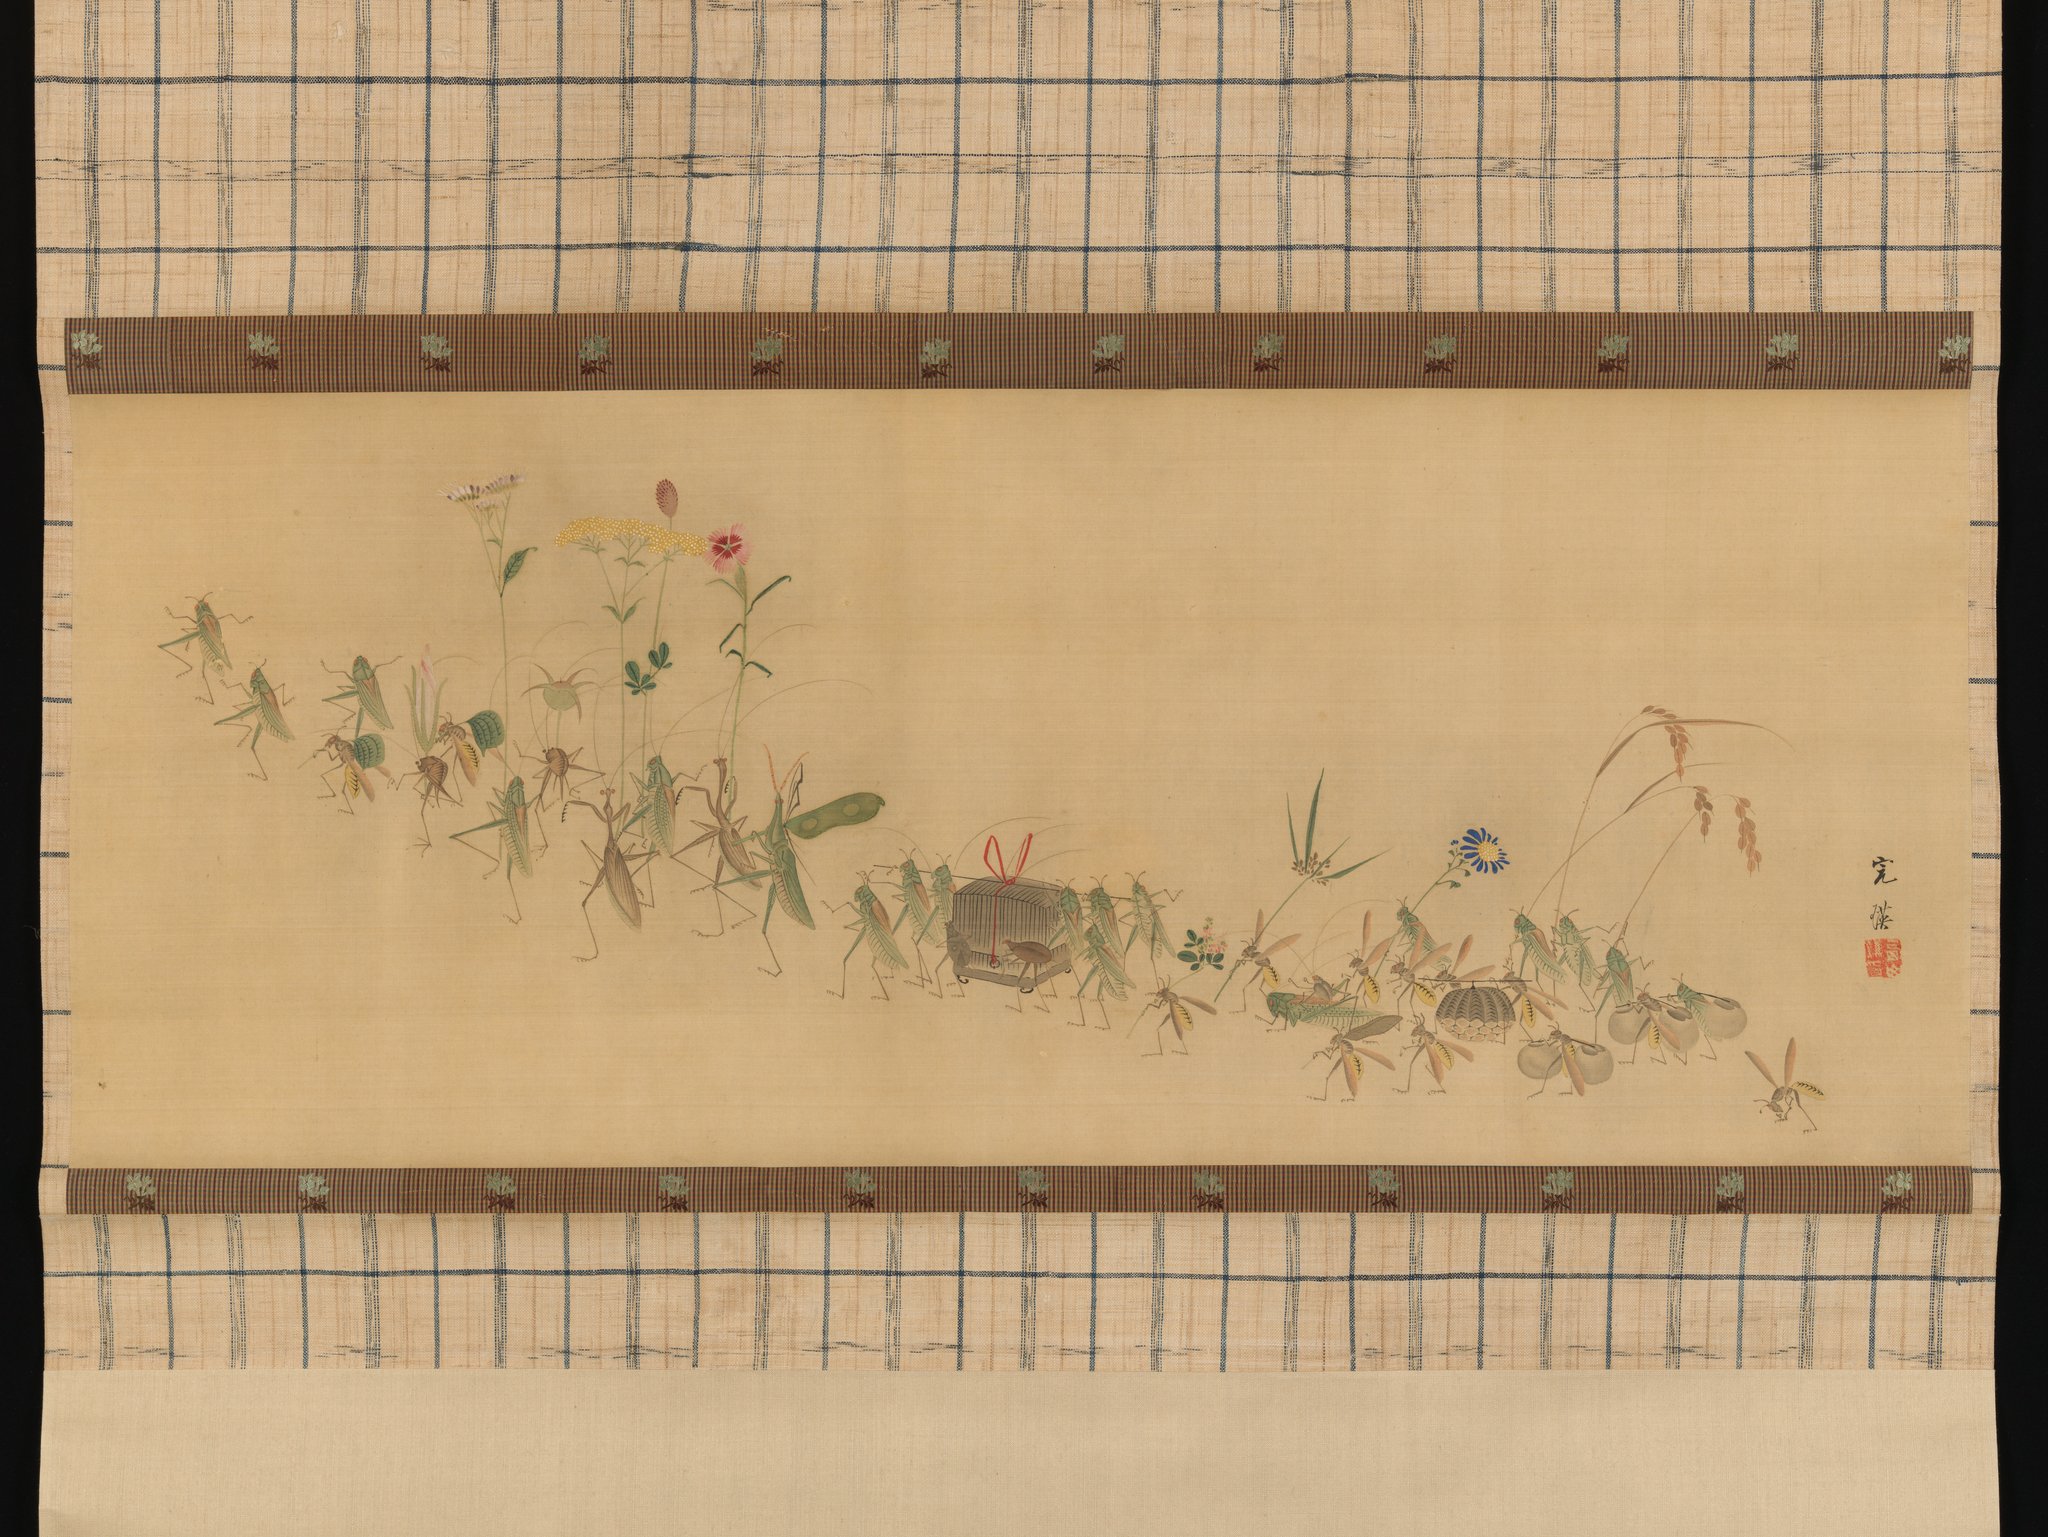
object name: hanging scroll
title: Procession of Insects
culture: japanese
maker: nishiyama kan'ei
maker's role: artist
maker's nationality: japanese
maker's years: 1834-1897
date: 1801-1900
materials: ink, silk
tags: insects